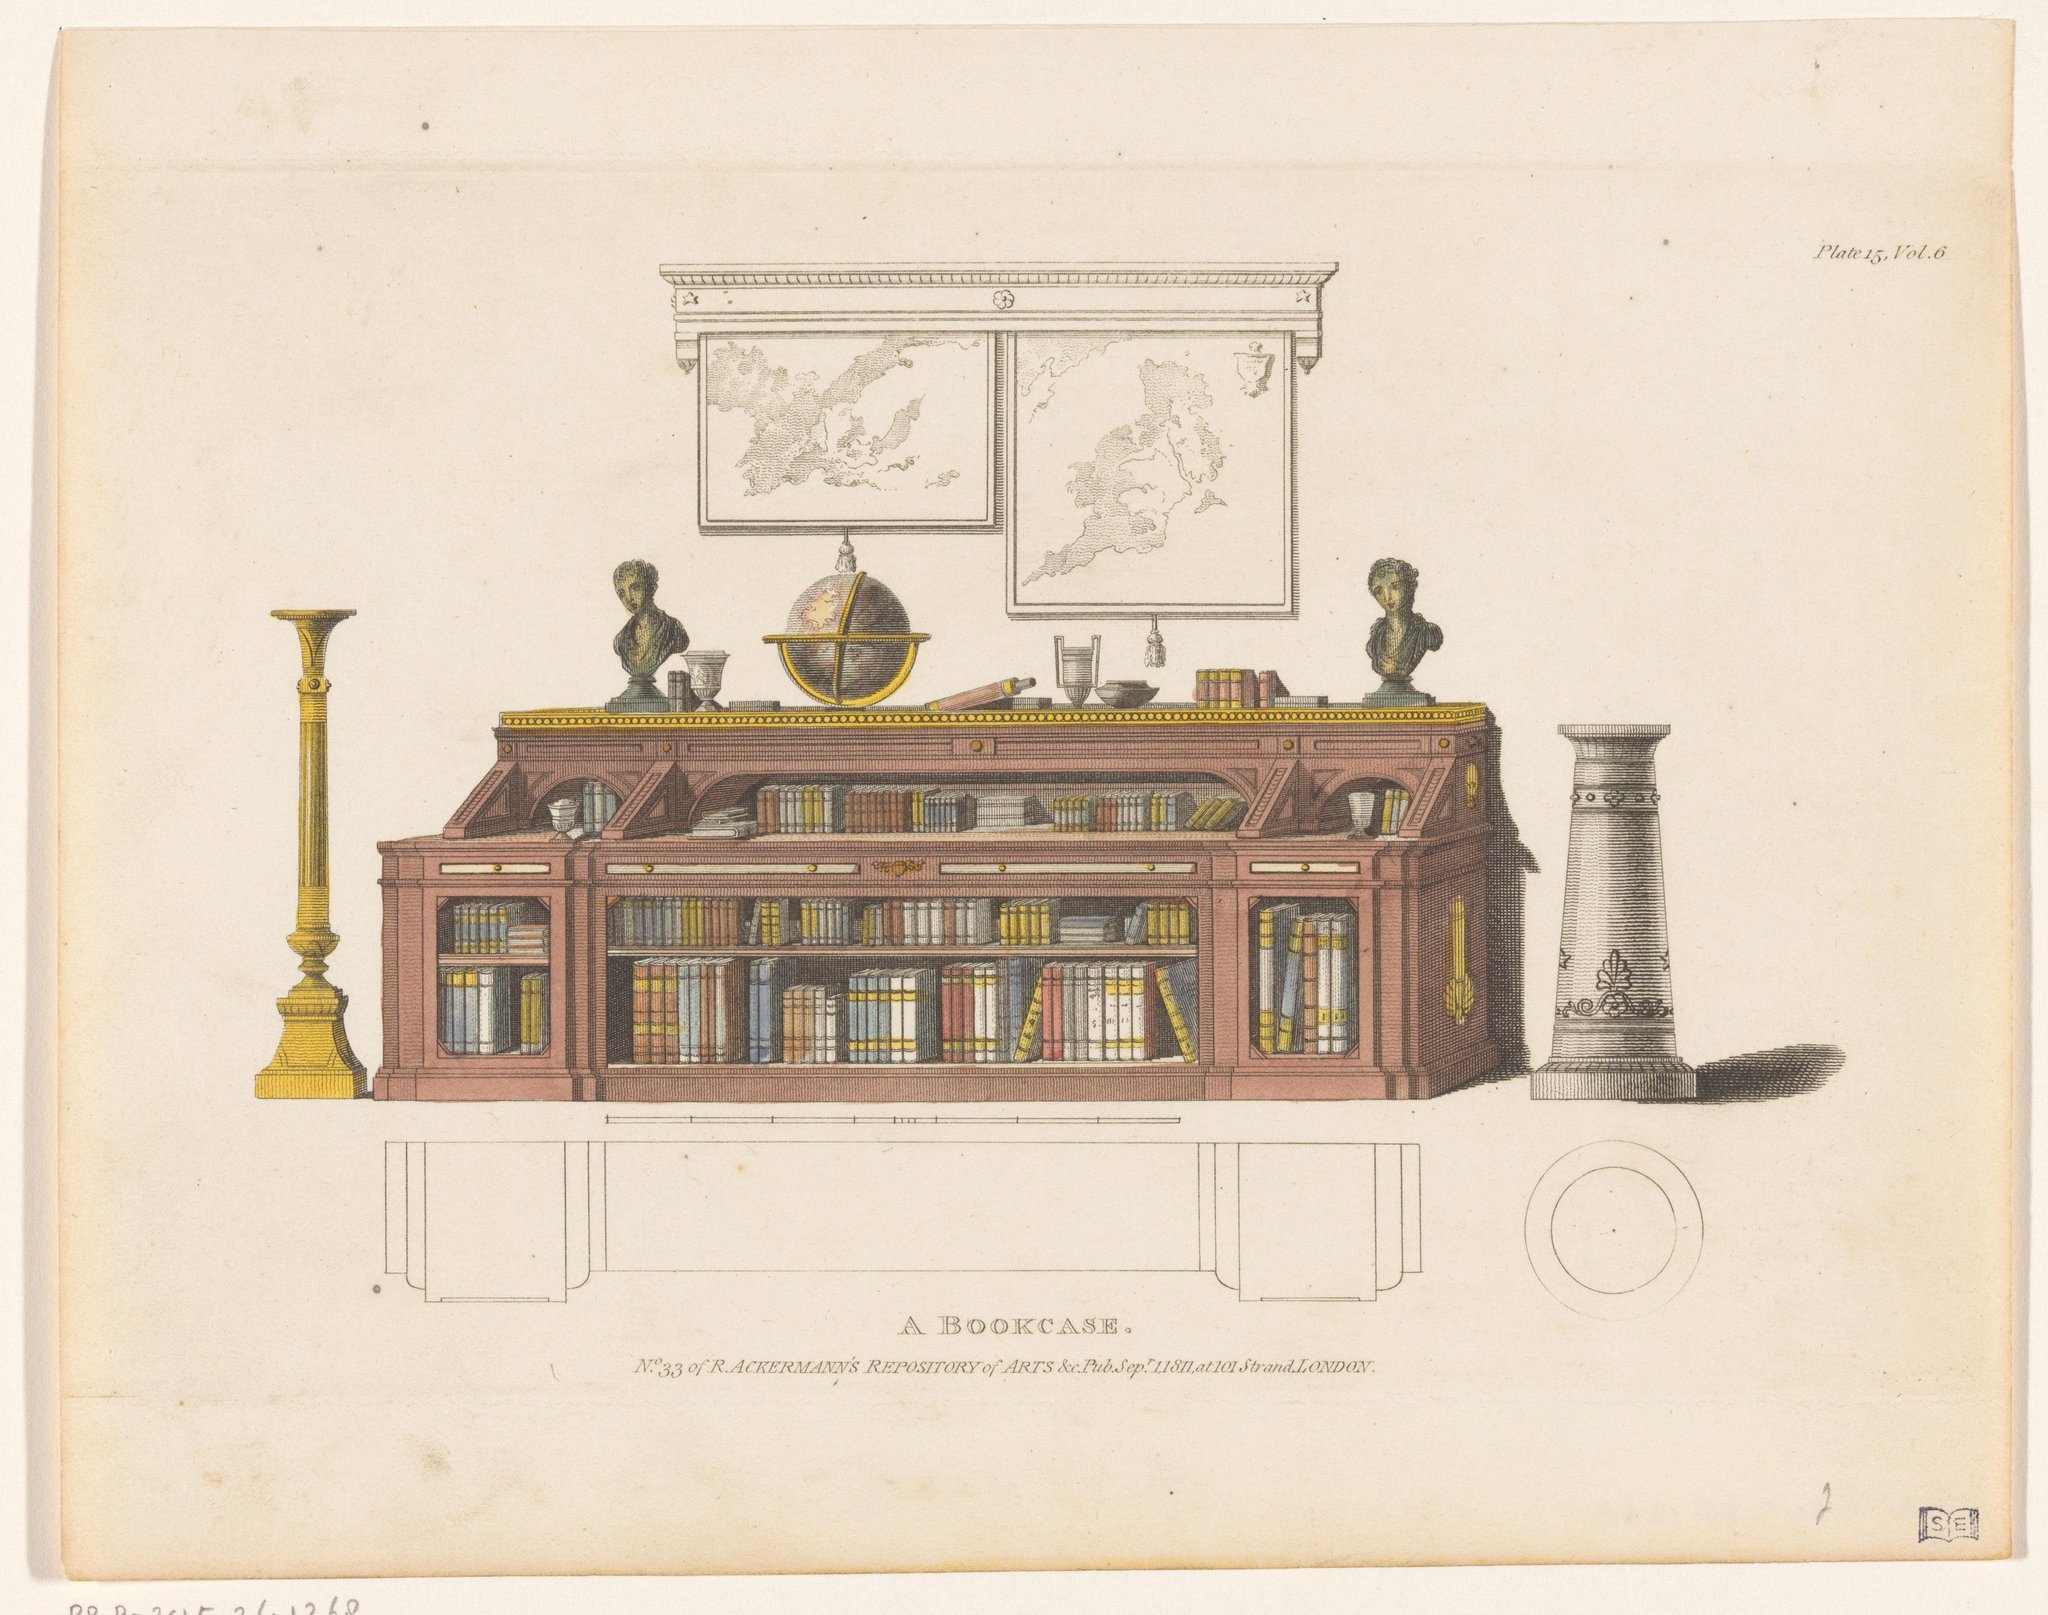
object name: print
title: A Bookcase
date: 1809-1811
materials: paper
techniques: etching, hand coloring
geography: london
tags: bookshelves, furniture for storage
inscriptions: collector's mark: Lugt 2228, collector's mark: Lugt 4780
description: Een boekenkast met bovenop een globe, twee bustes en andere voorwerpen. Boven de boekenkast hangen twee landkaarten. Rechtsboven genummerd: Plate 15. Vol. 6.